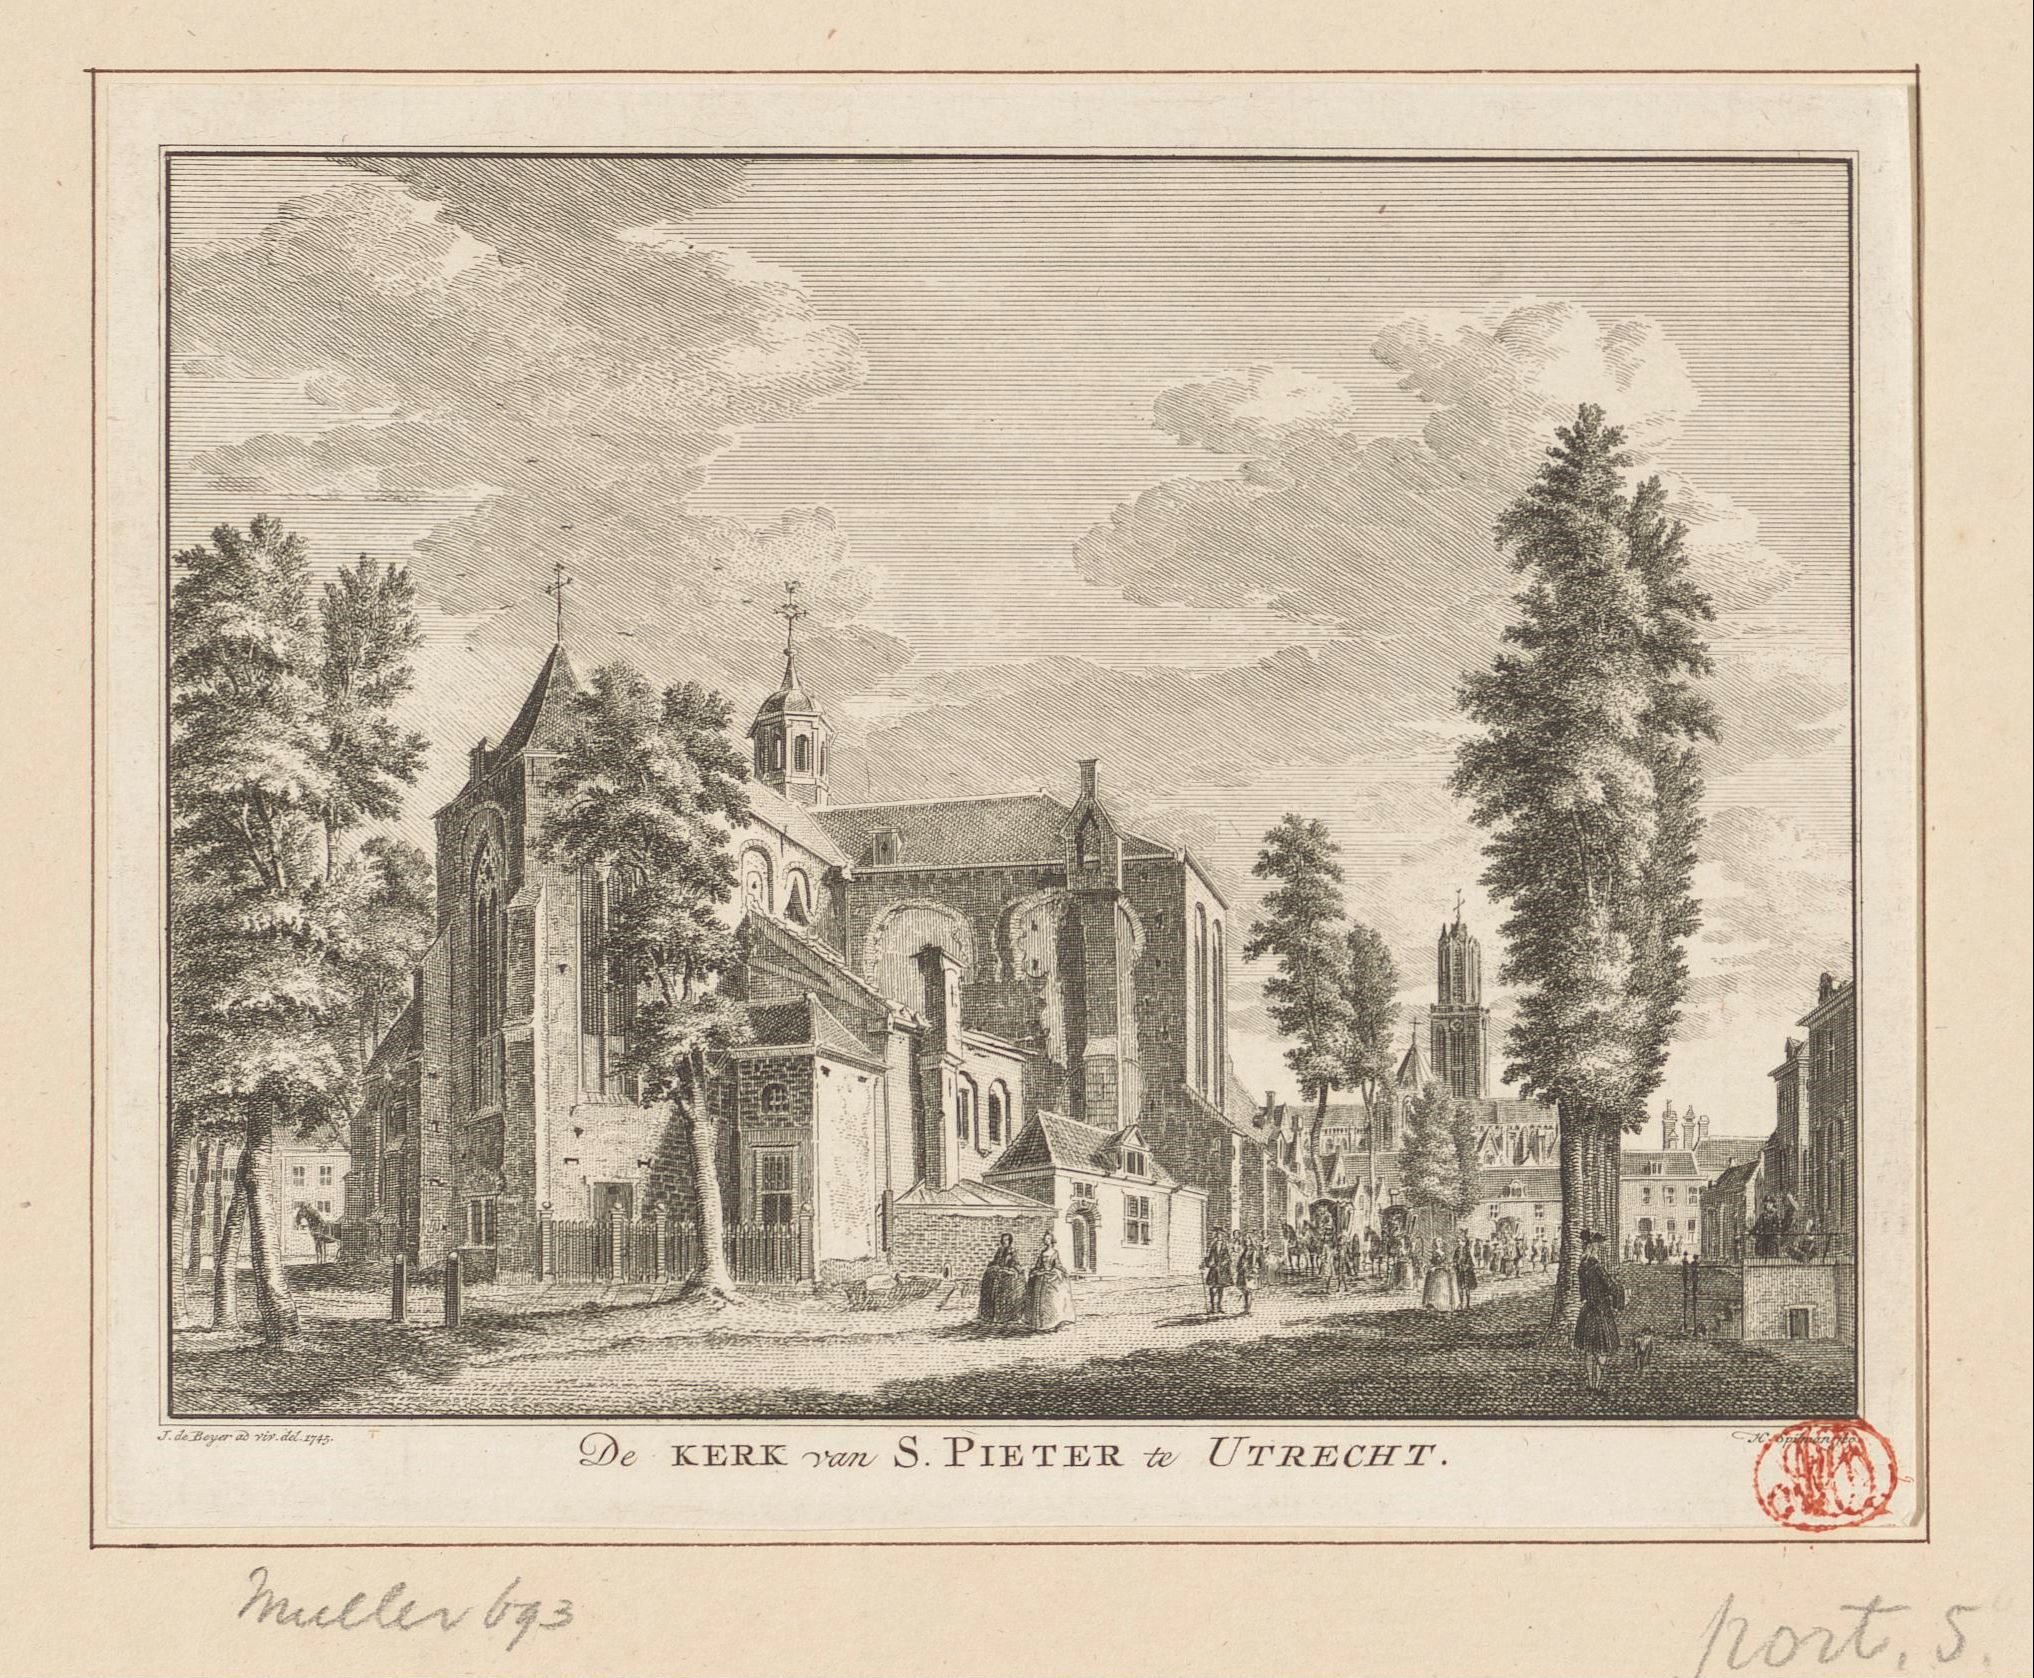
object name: book illustration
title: Gezicht op de Pieterskerk te Utrecht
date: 1745-1758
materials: paper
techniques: engraving, etching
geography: amsterdam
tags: square, place, circus, etc., church (exterior)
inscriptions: collector's mark: Lugt 195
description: Prent ook gebruikt in: Tegenwoordige staat der Vereenigde Nederlanden, elfde deel, behelzende eene beschryving van de provincie van Utrecht. Met landkaarten, plans der steden en printverbeeldingen versierd / Hedendaagsche historie, of tegenwoordige staat van alle volkeren; XXI. deel (…). Amsterdam: Isaak Tirion, 1758, tussen p. 370 en p. 371.